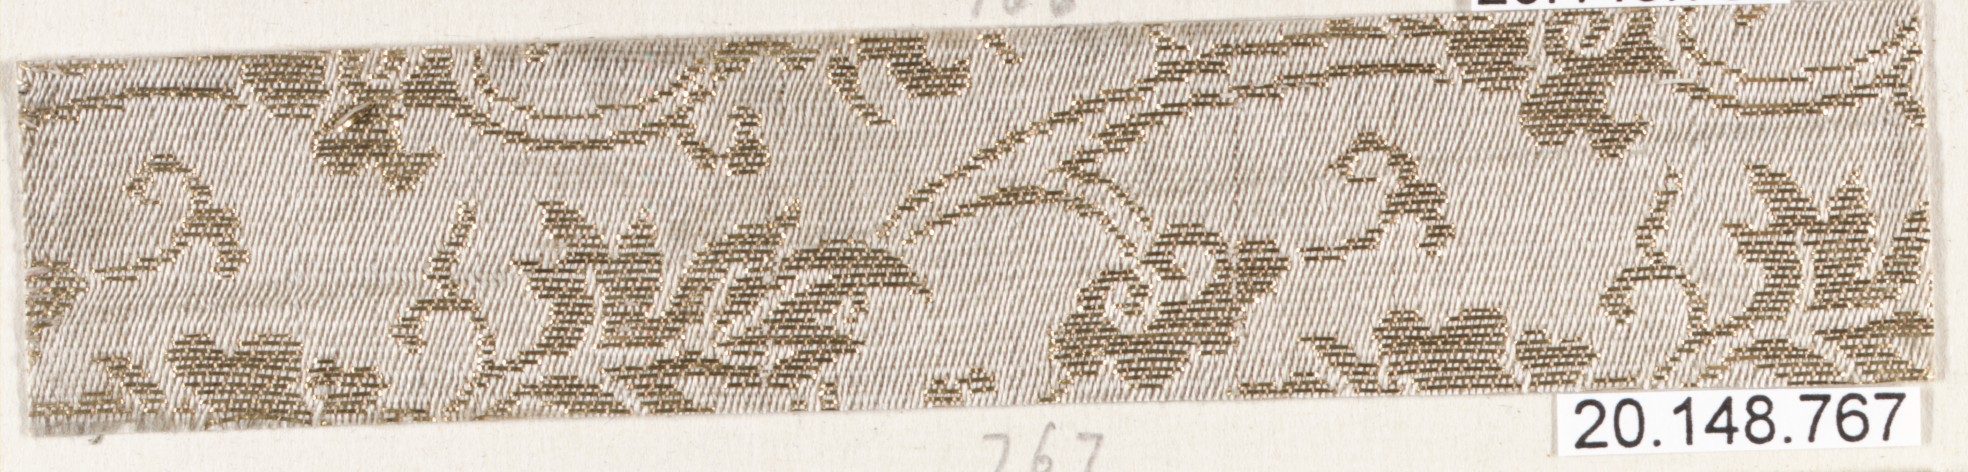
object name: piece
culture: japanese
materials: silk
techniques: compound weave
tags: leaves